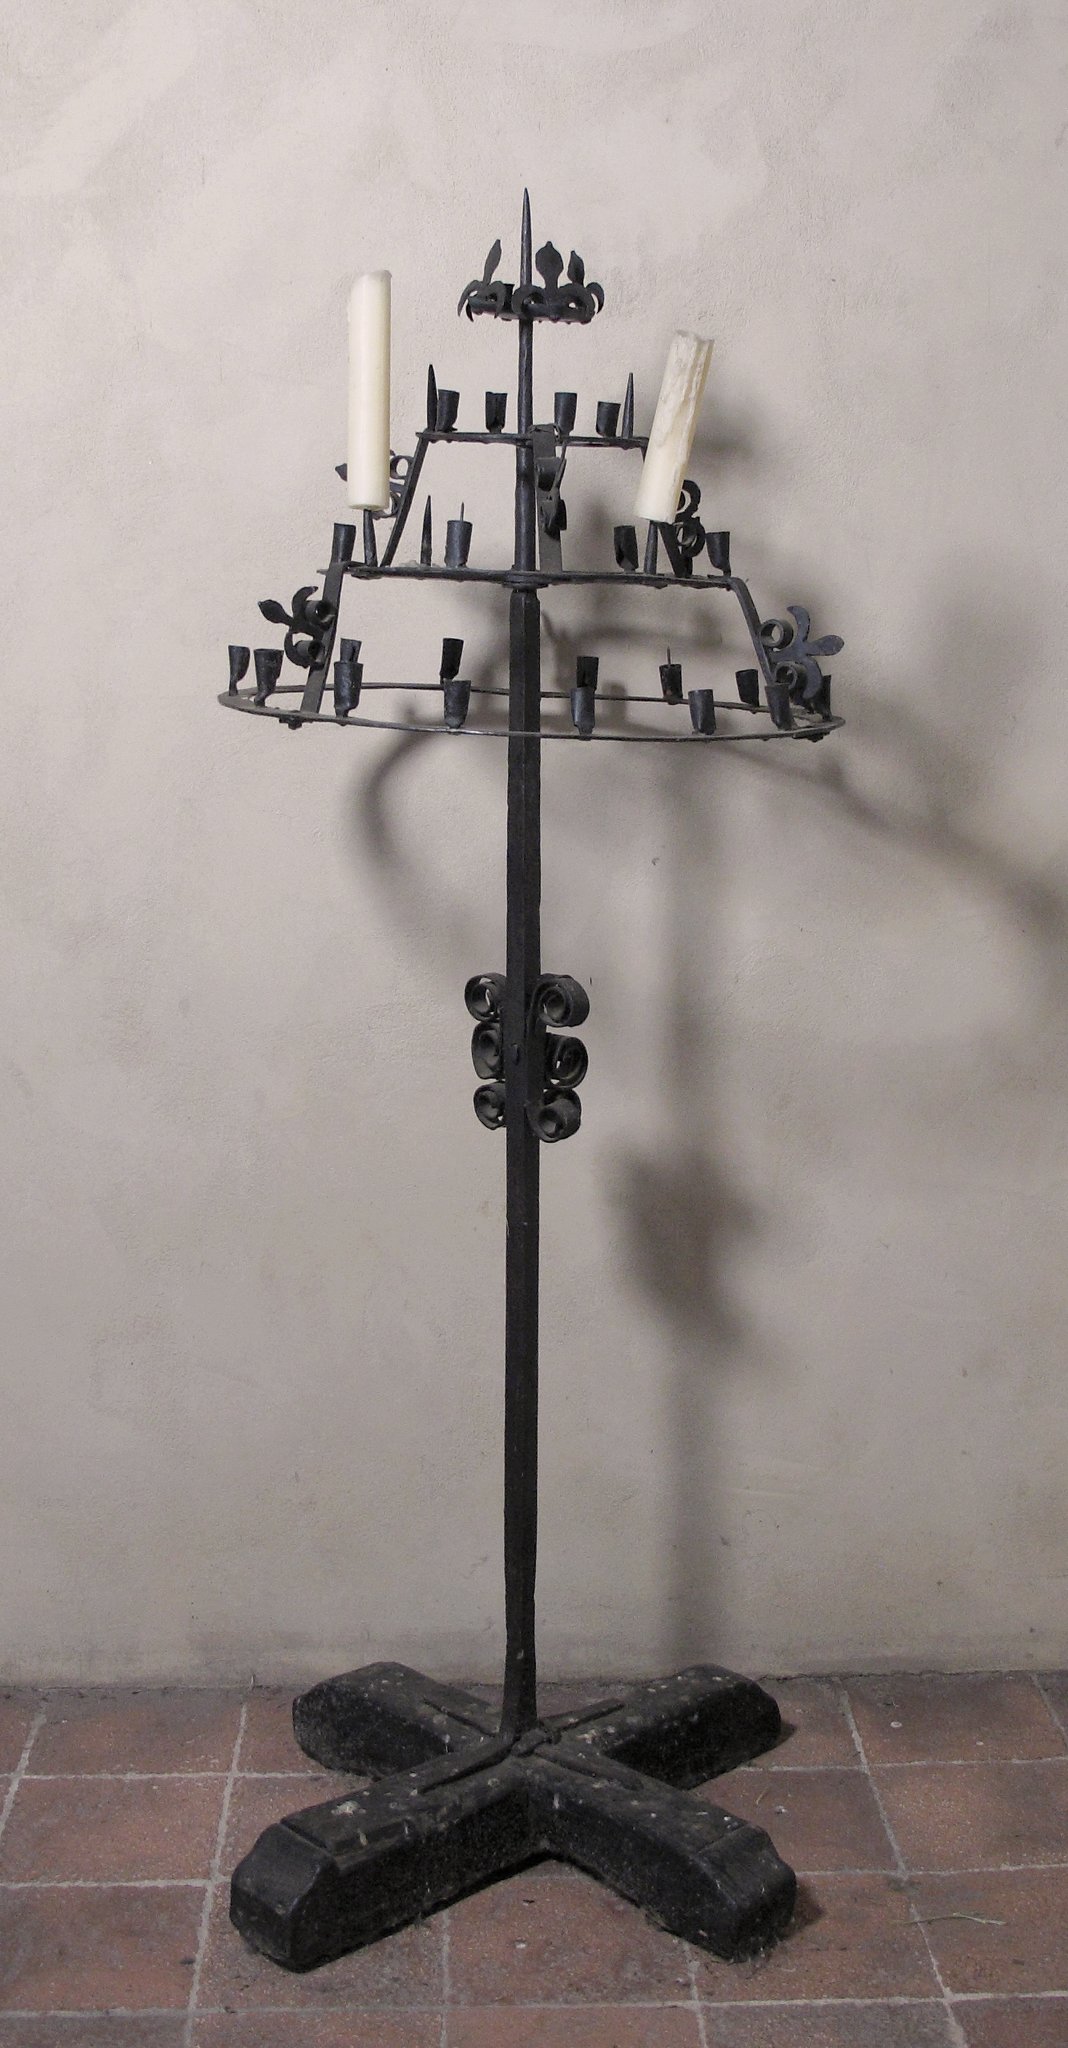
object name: candelabrum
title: Candelabra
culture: european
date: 1501-1600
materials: iron